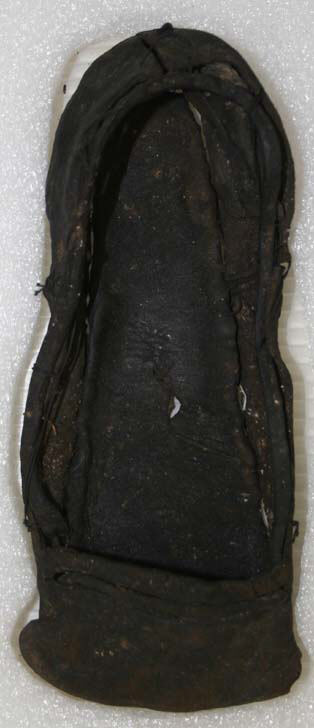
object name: shoe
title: Shoes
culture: british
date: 1501-1600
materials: leather